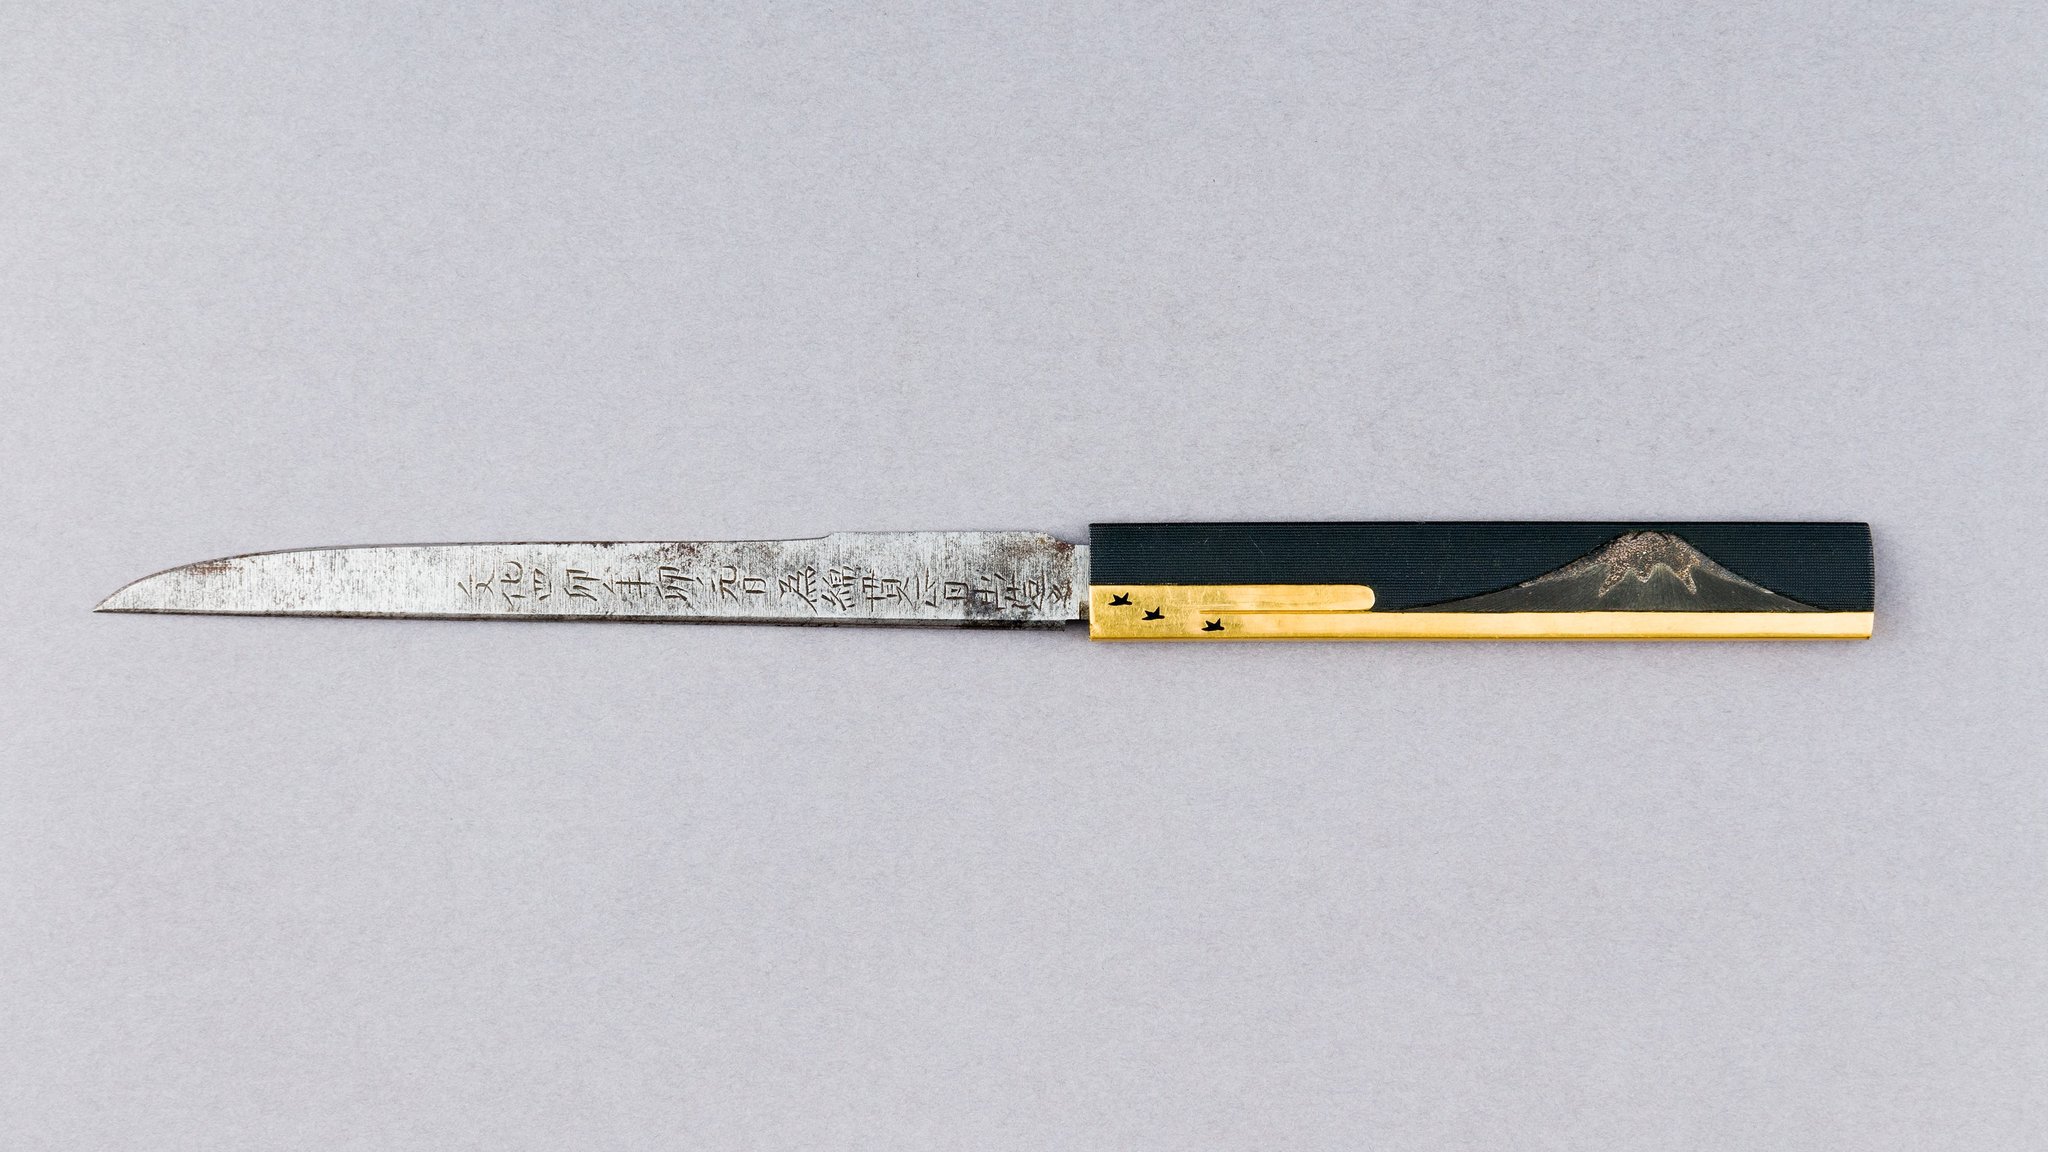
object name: 富嶽雲烟図小柄 knife handle i kozuka i with blade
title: 富嶽雲烟図小柄 Knife Handle (Kozuka) with Blade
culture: japanese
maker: 嵐山常行画 ranzan tsuneyuki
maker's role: fittings maker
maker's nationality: japanese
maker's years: 1825-1875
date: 1801-1900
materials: gold alloy, gold, steel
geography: japan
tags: mountains